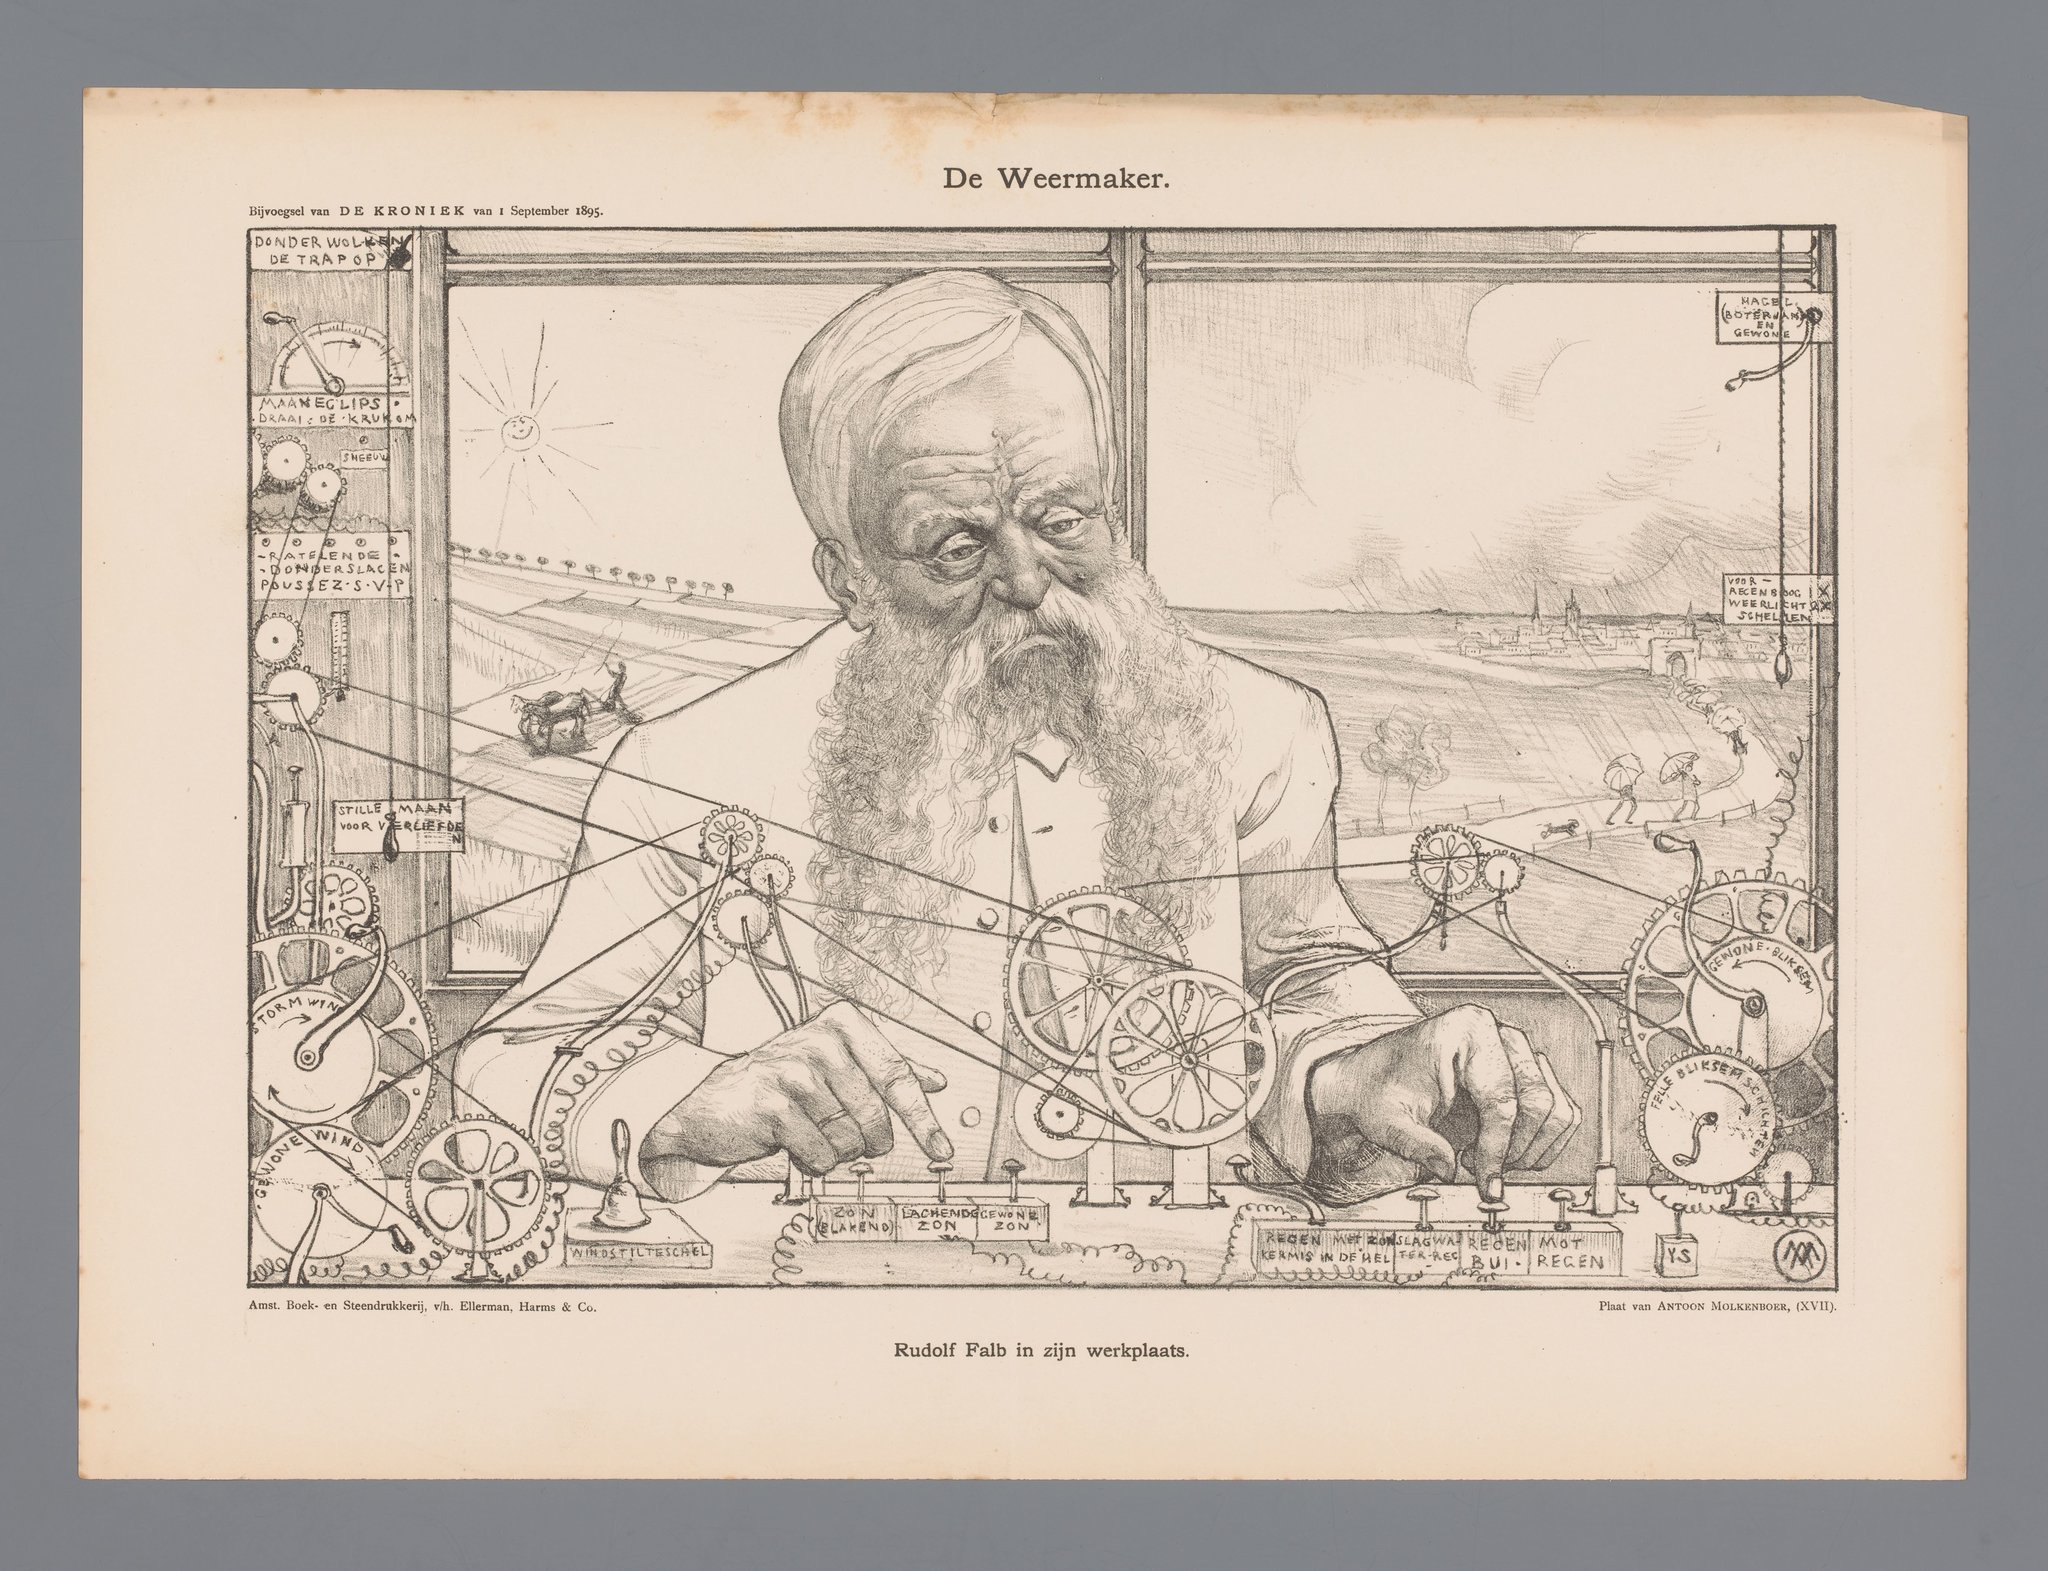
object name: cartoon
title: De Weermaker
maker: anton molkenboer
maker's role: print maker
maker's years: 1872-1960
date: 1895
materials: paper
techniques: lithograph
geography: amsterdam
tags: austria, physicist, good and bad weather, meteorology (+ portrait of scholar, scientist), historical persons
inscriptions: date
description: Prent uit het bijvoegsel van: De Kroniek 1 (1895), 1 september 1895.